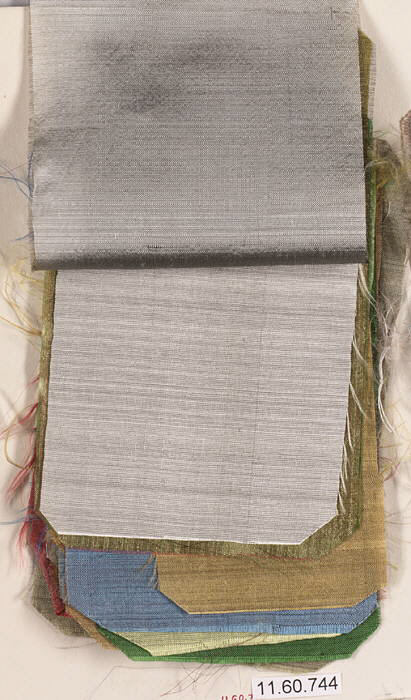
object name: sample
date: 1801-1833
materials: silk